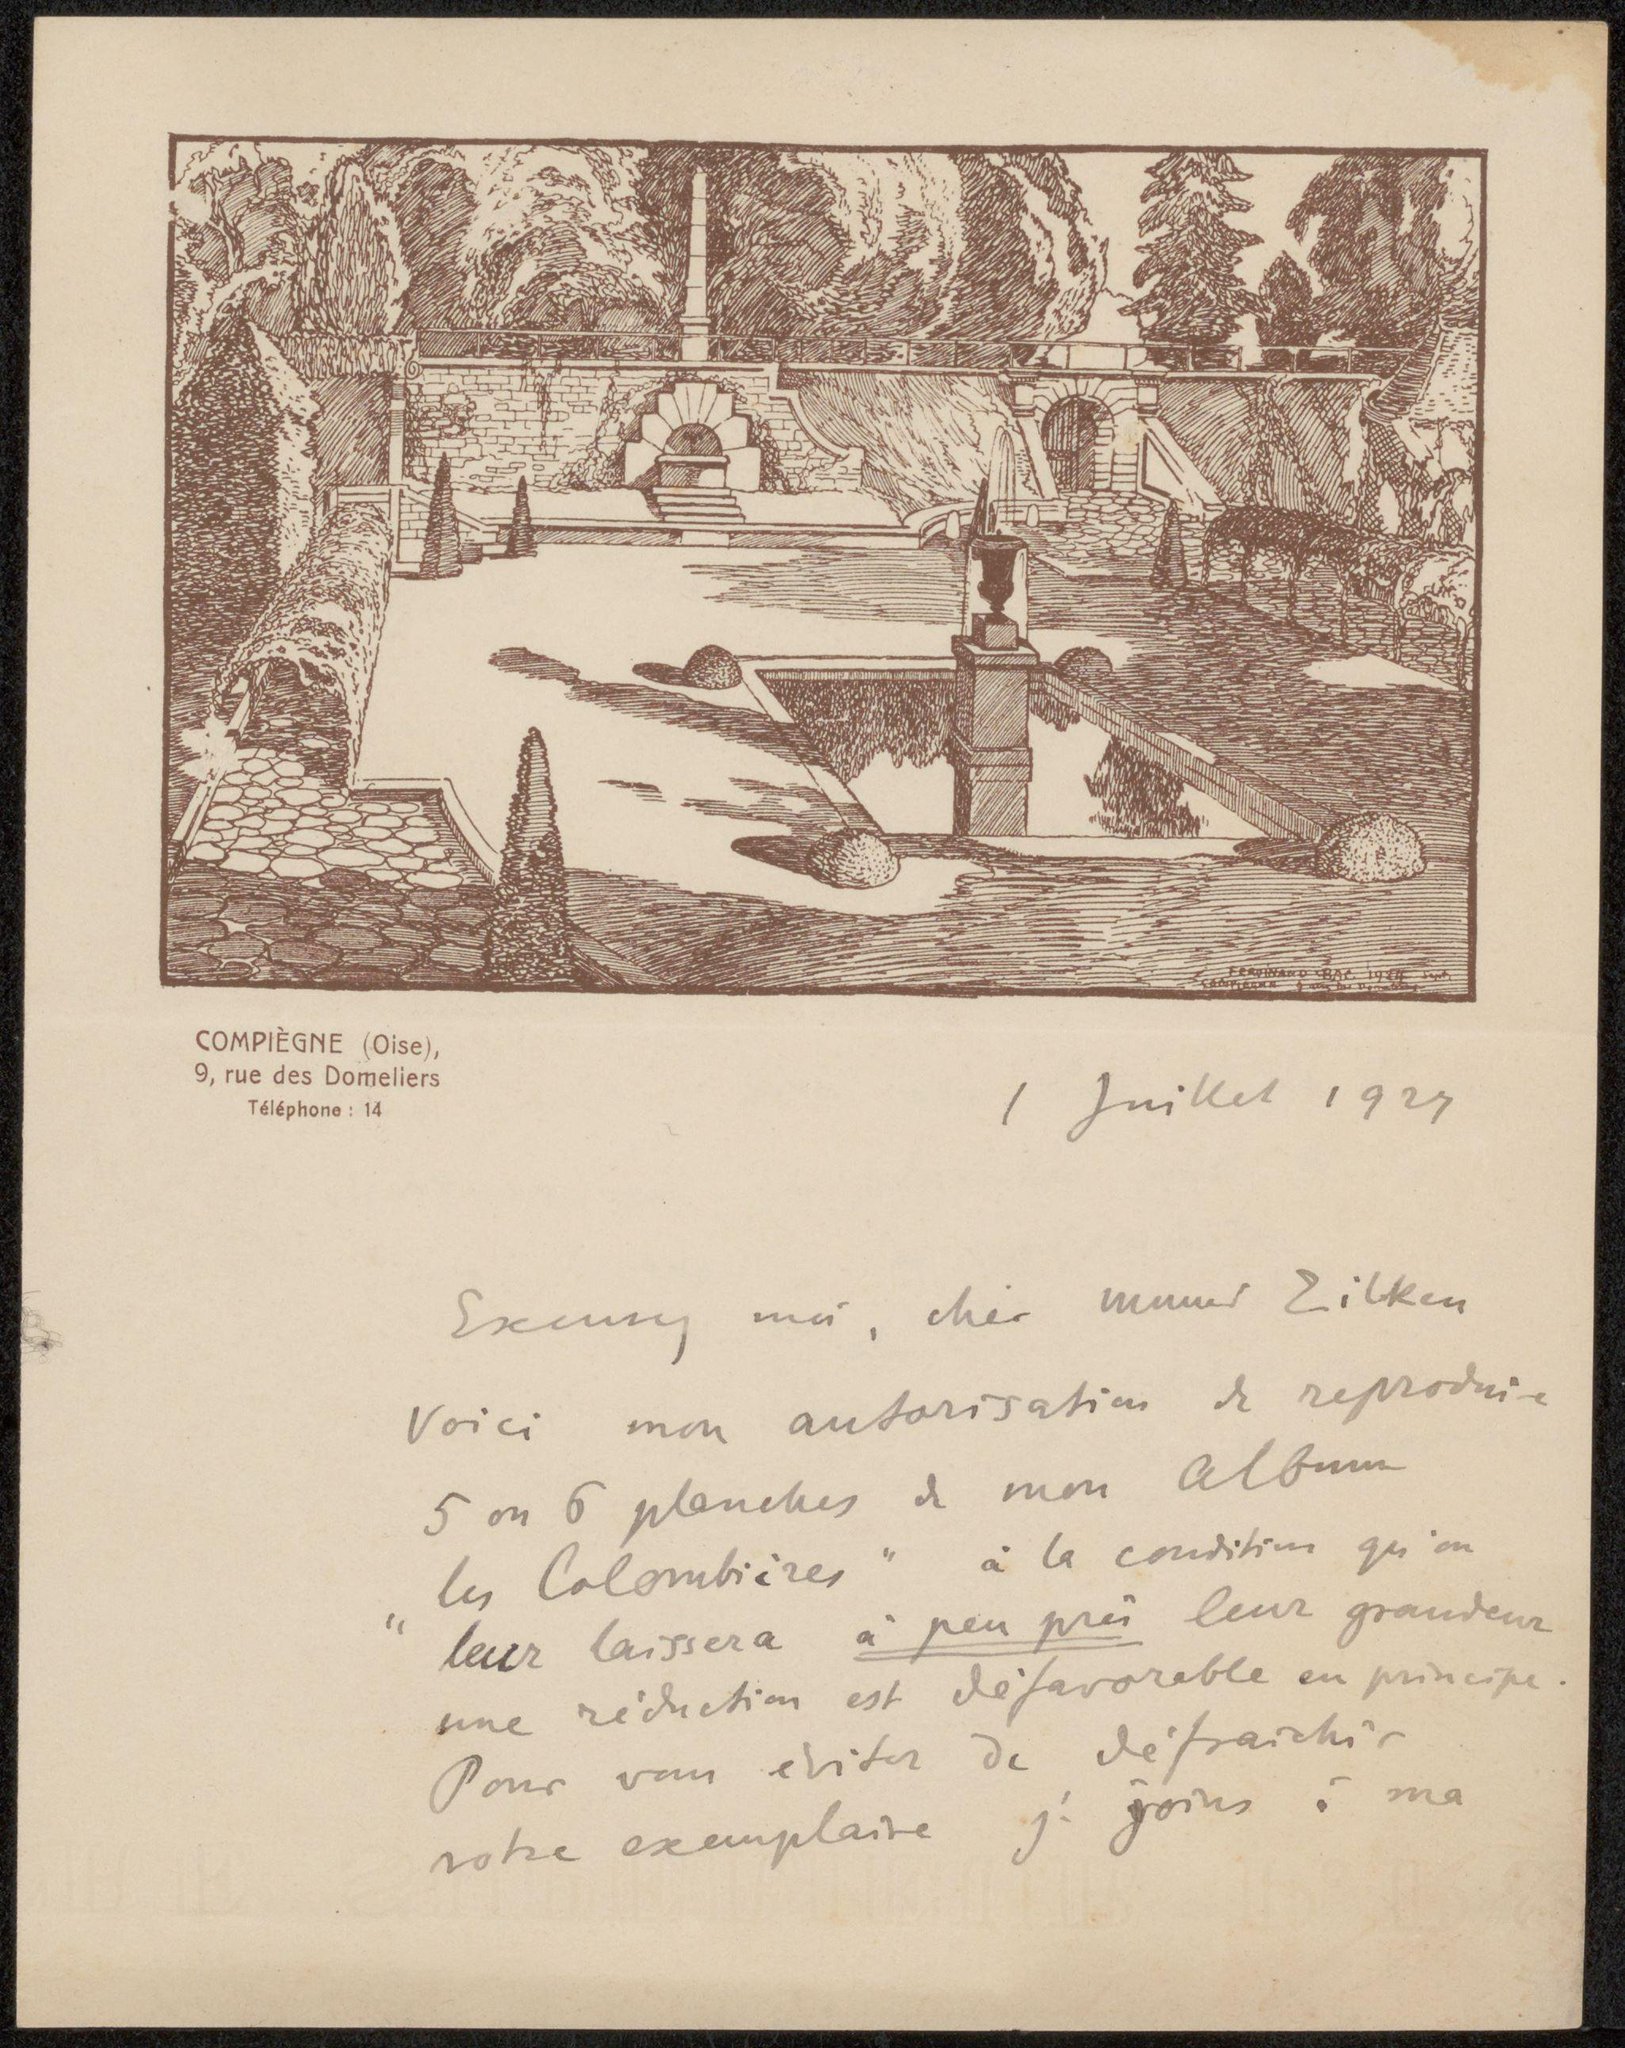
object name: letter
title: Brief aan Philip Zilcken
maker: ferdinand-sigismund bac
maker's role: draughtsman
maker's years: 1859-1952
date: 1927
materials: ink, paper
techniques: pen, printing, writing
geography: compiègne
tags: the hague, painter, philip zilcken, the graphic arts, printed matter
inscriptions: collector's mark: ‘RPK’